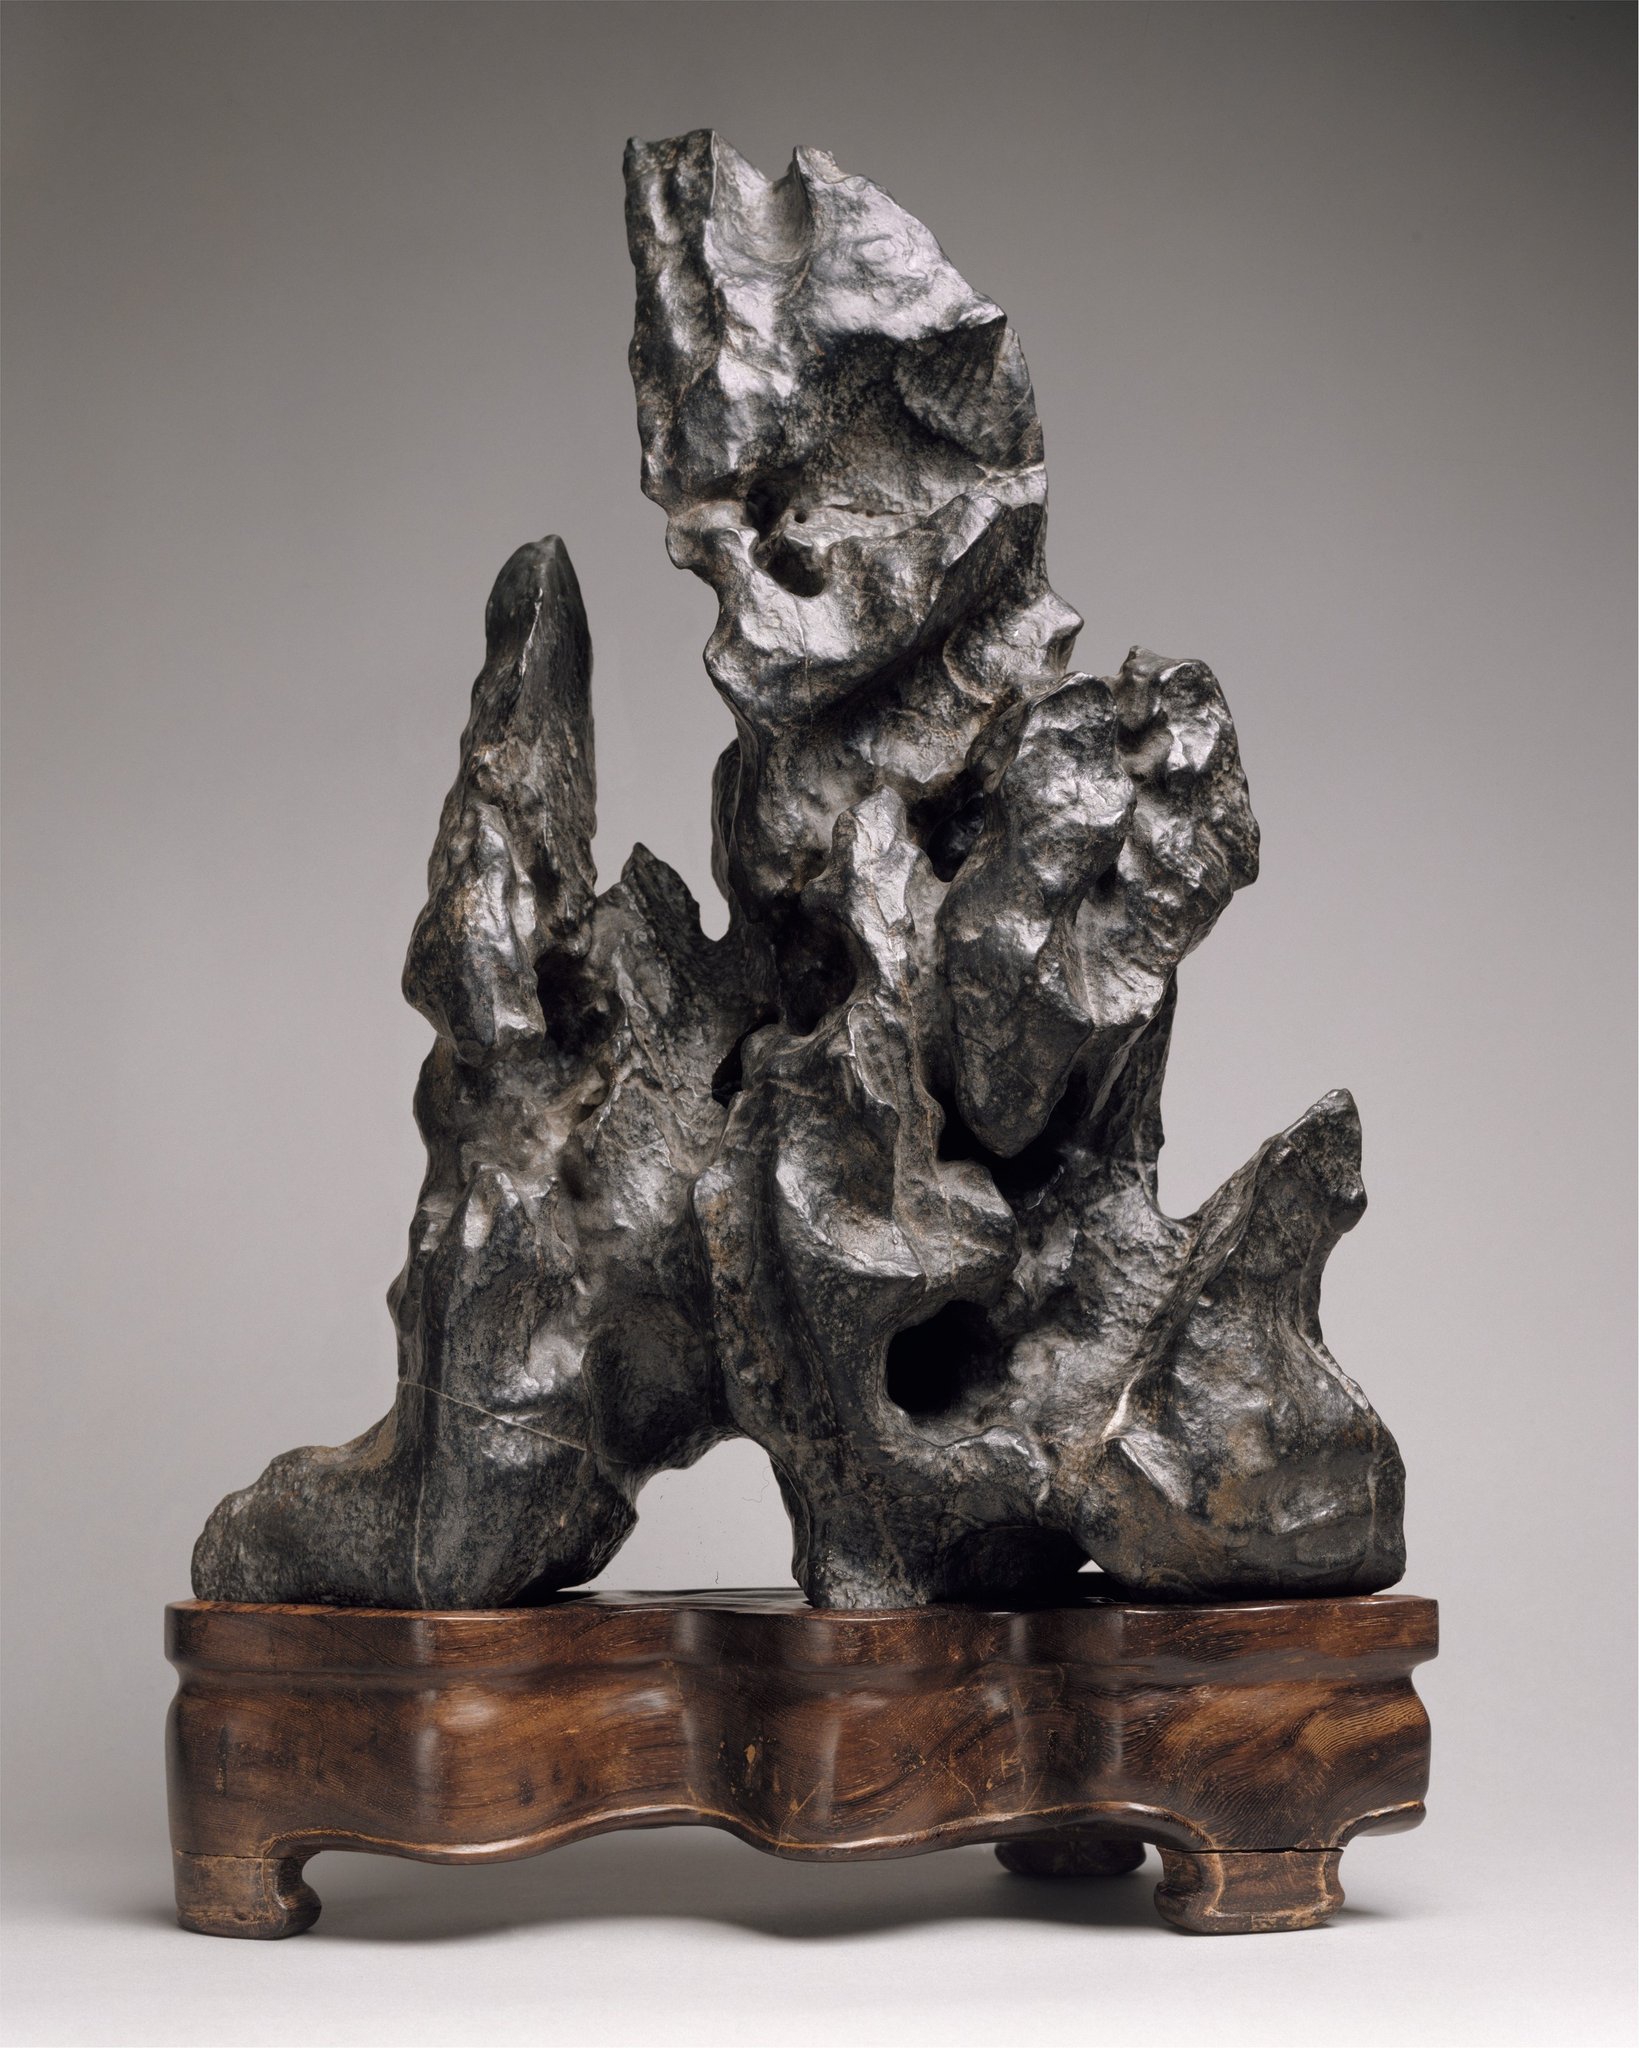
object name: scholar's rock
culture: chinese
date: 1662-1722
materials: limestone, wood